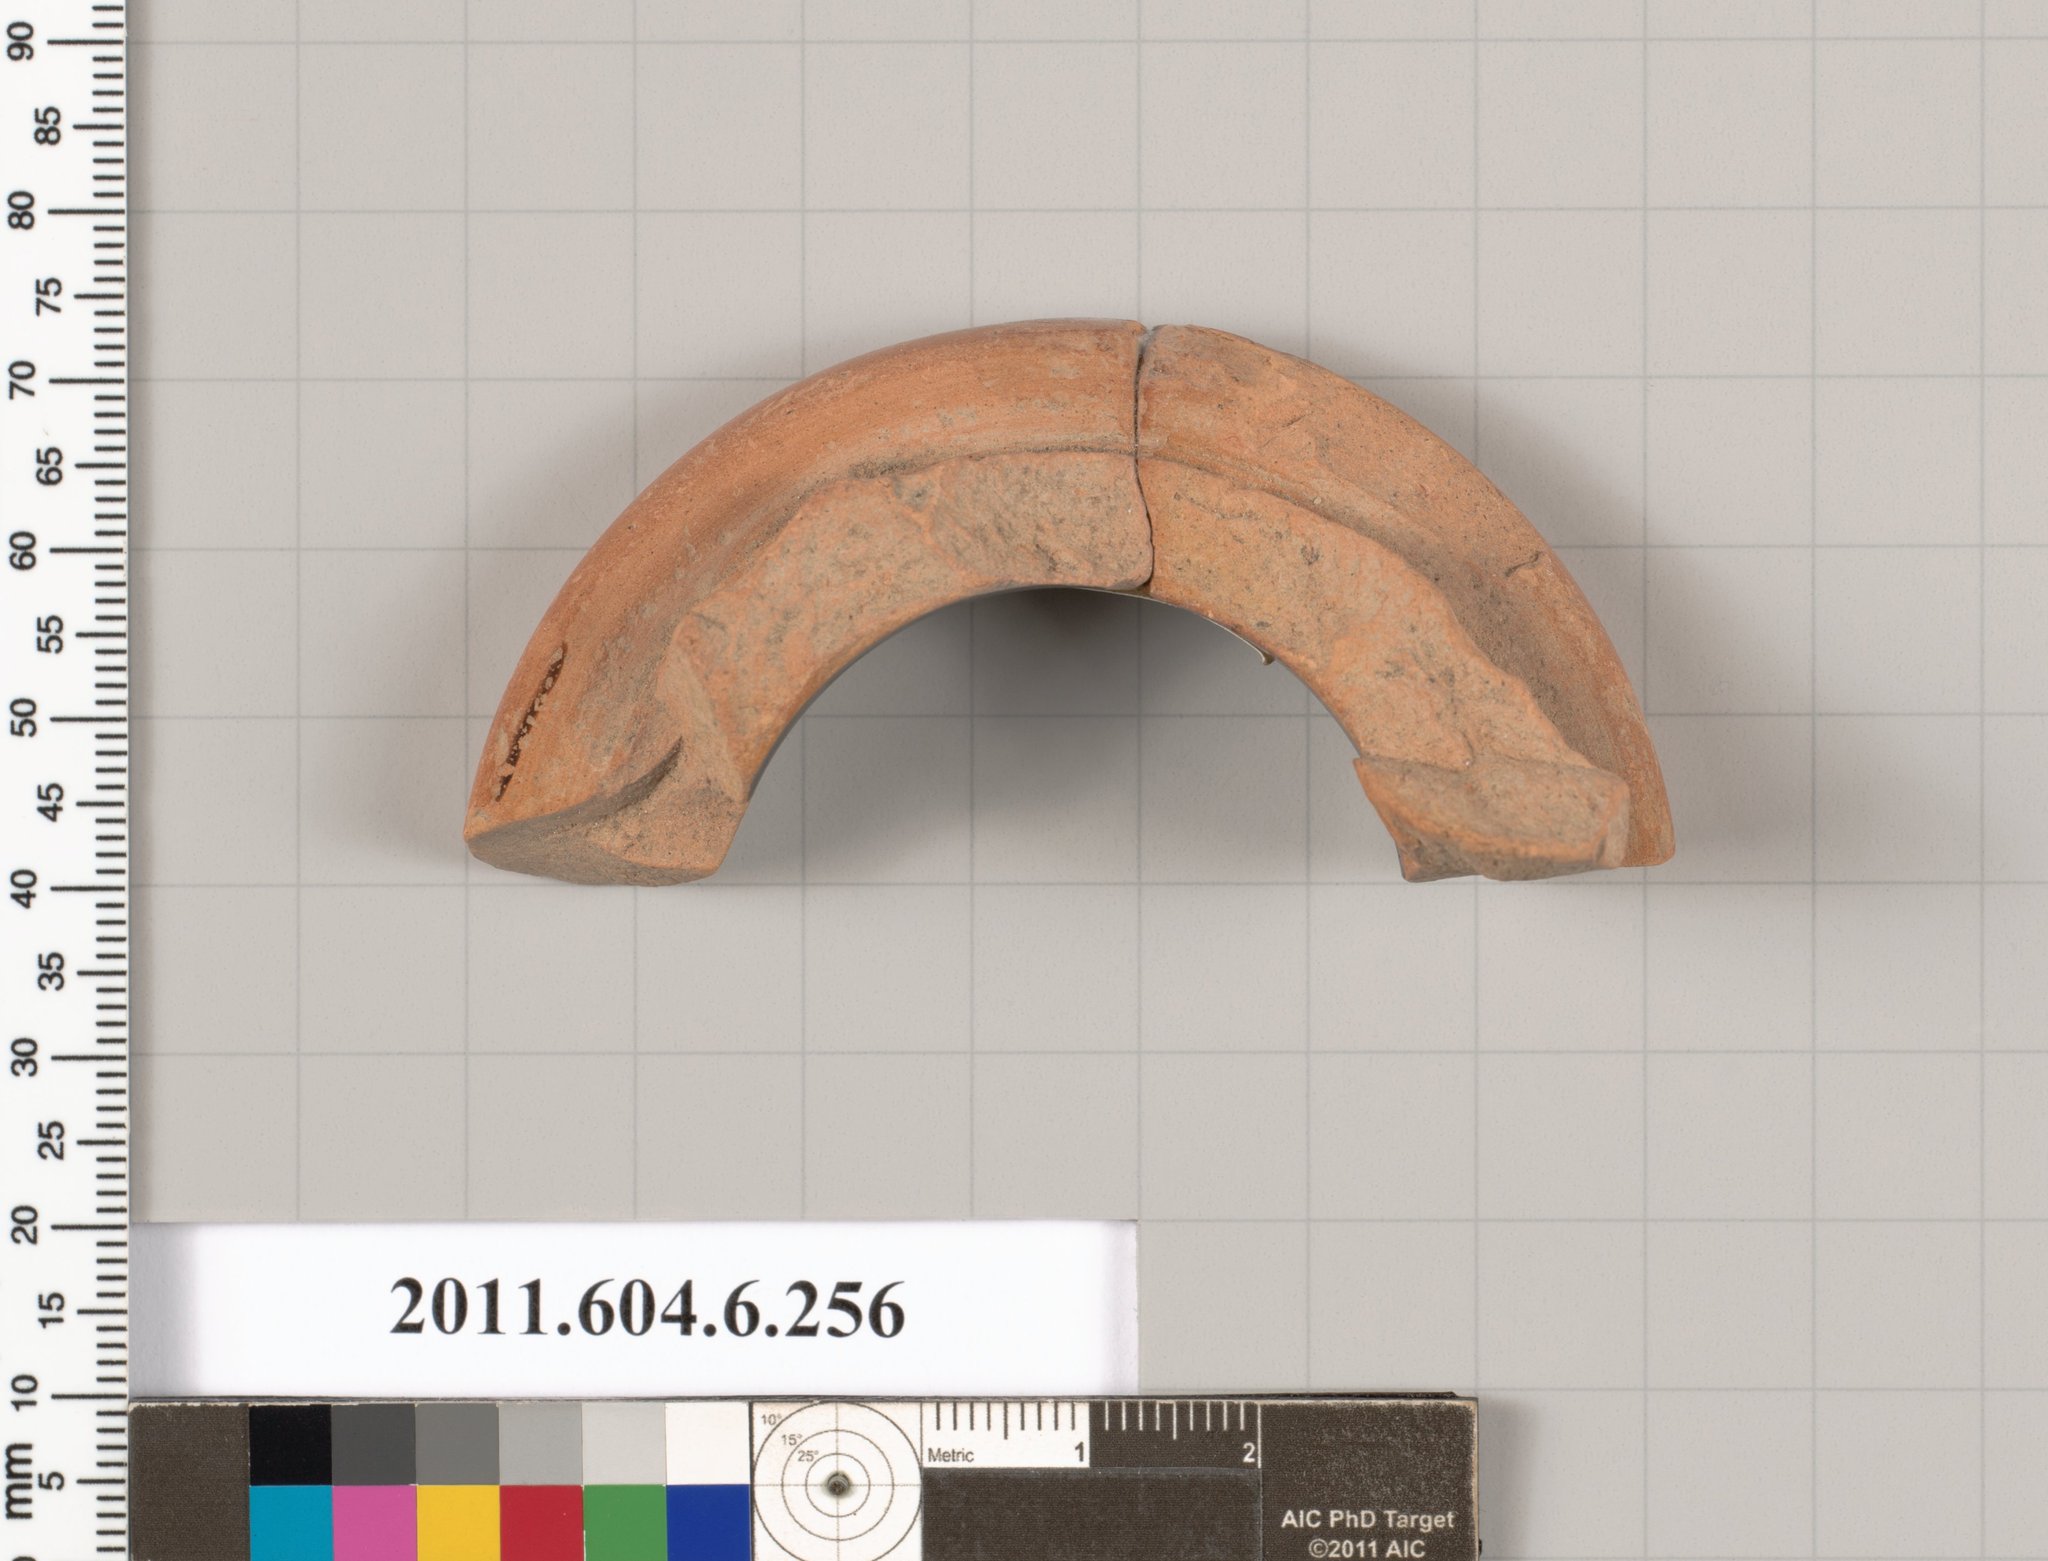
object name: undetermined shape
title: Terracotta fragment of an undetermined shape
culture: greek, attic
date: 600-401 BCE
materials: terracotta